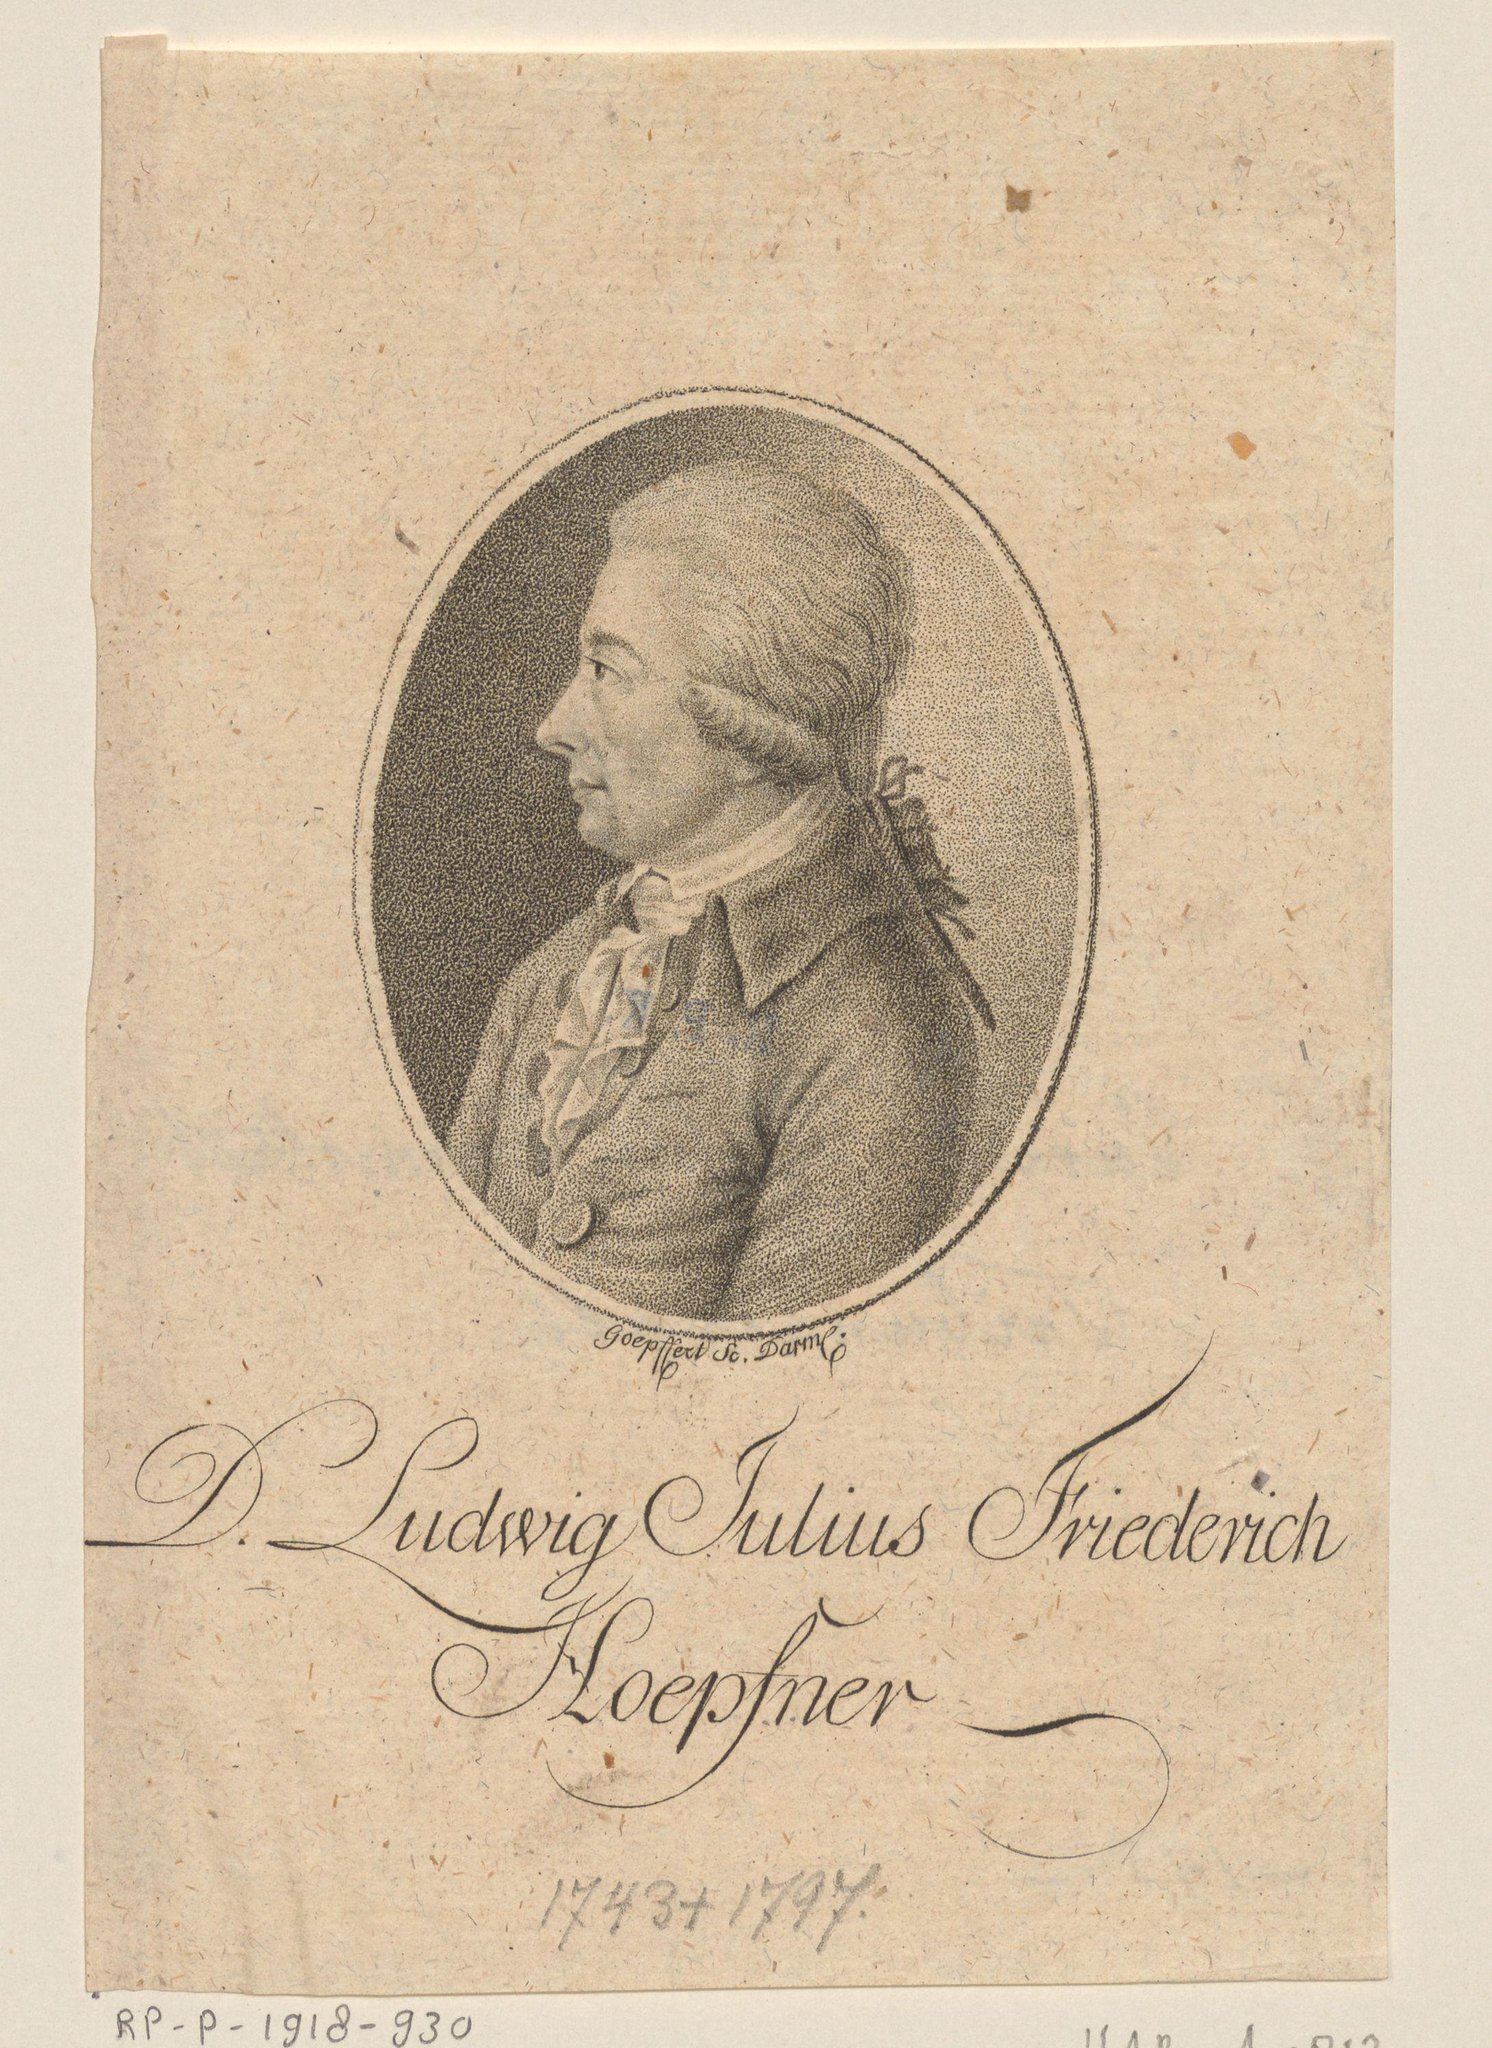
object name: print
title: Portret van Ludwig Höpfner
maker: karl goepfert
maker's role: print maker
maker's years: 1760-1788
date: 1770-1788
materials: paper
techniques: engraving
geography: darmstadt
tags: historical persons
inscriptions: collector's mark: Lugt 2233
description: Prent gebruikt in: Allgemeine deutsche Bibliothek. Berlijn en Stettin: Friedrich Nicolai, 1788, dl. 83-1.